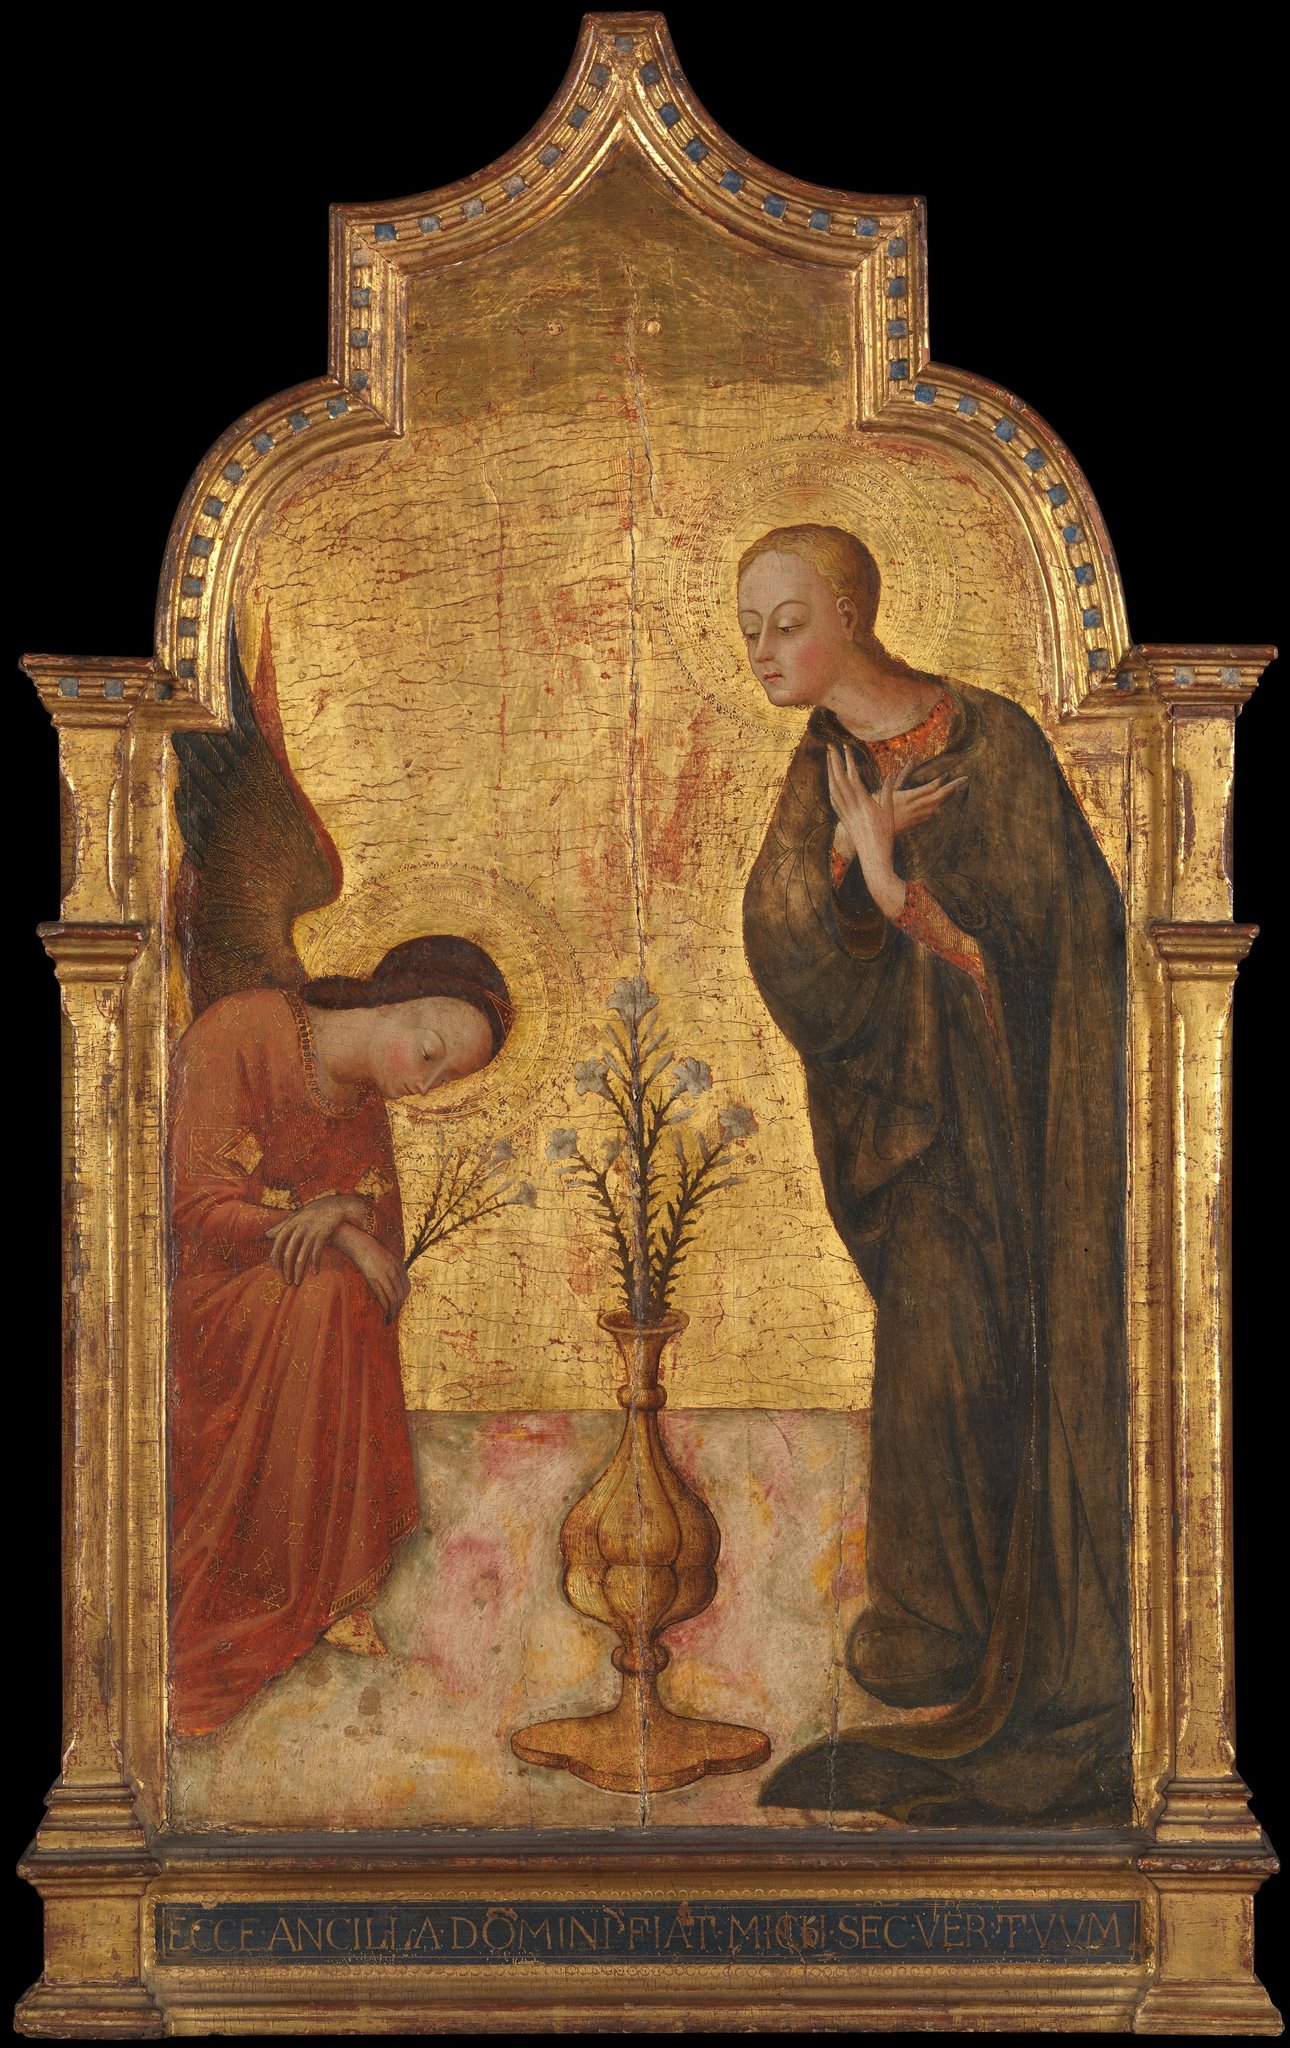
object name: painting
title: The Annunciation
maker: sassetta (stefano di giovanni)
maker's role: artist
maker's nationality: italian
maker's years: 1400-1450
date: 1435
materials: gold leaf, paint, wood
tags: annunciation